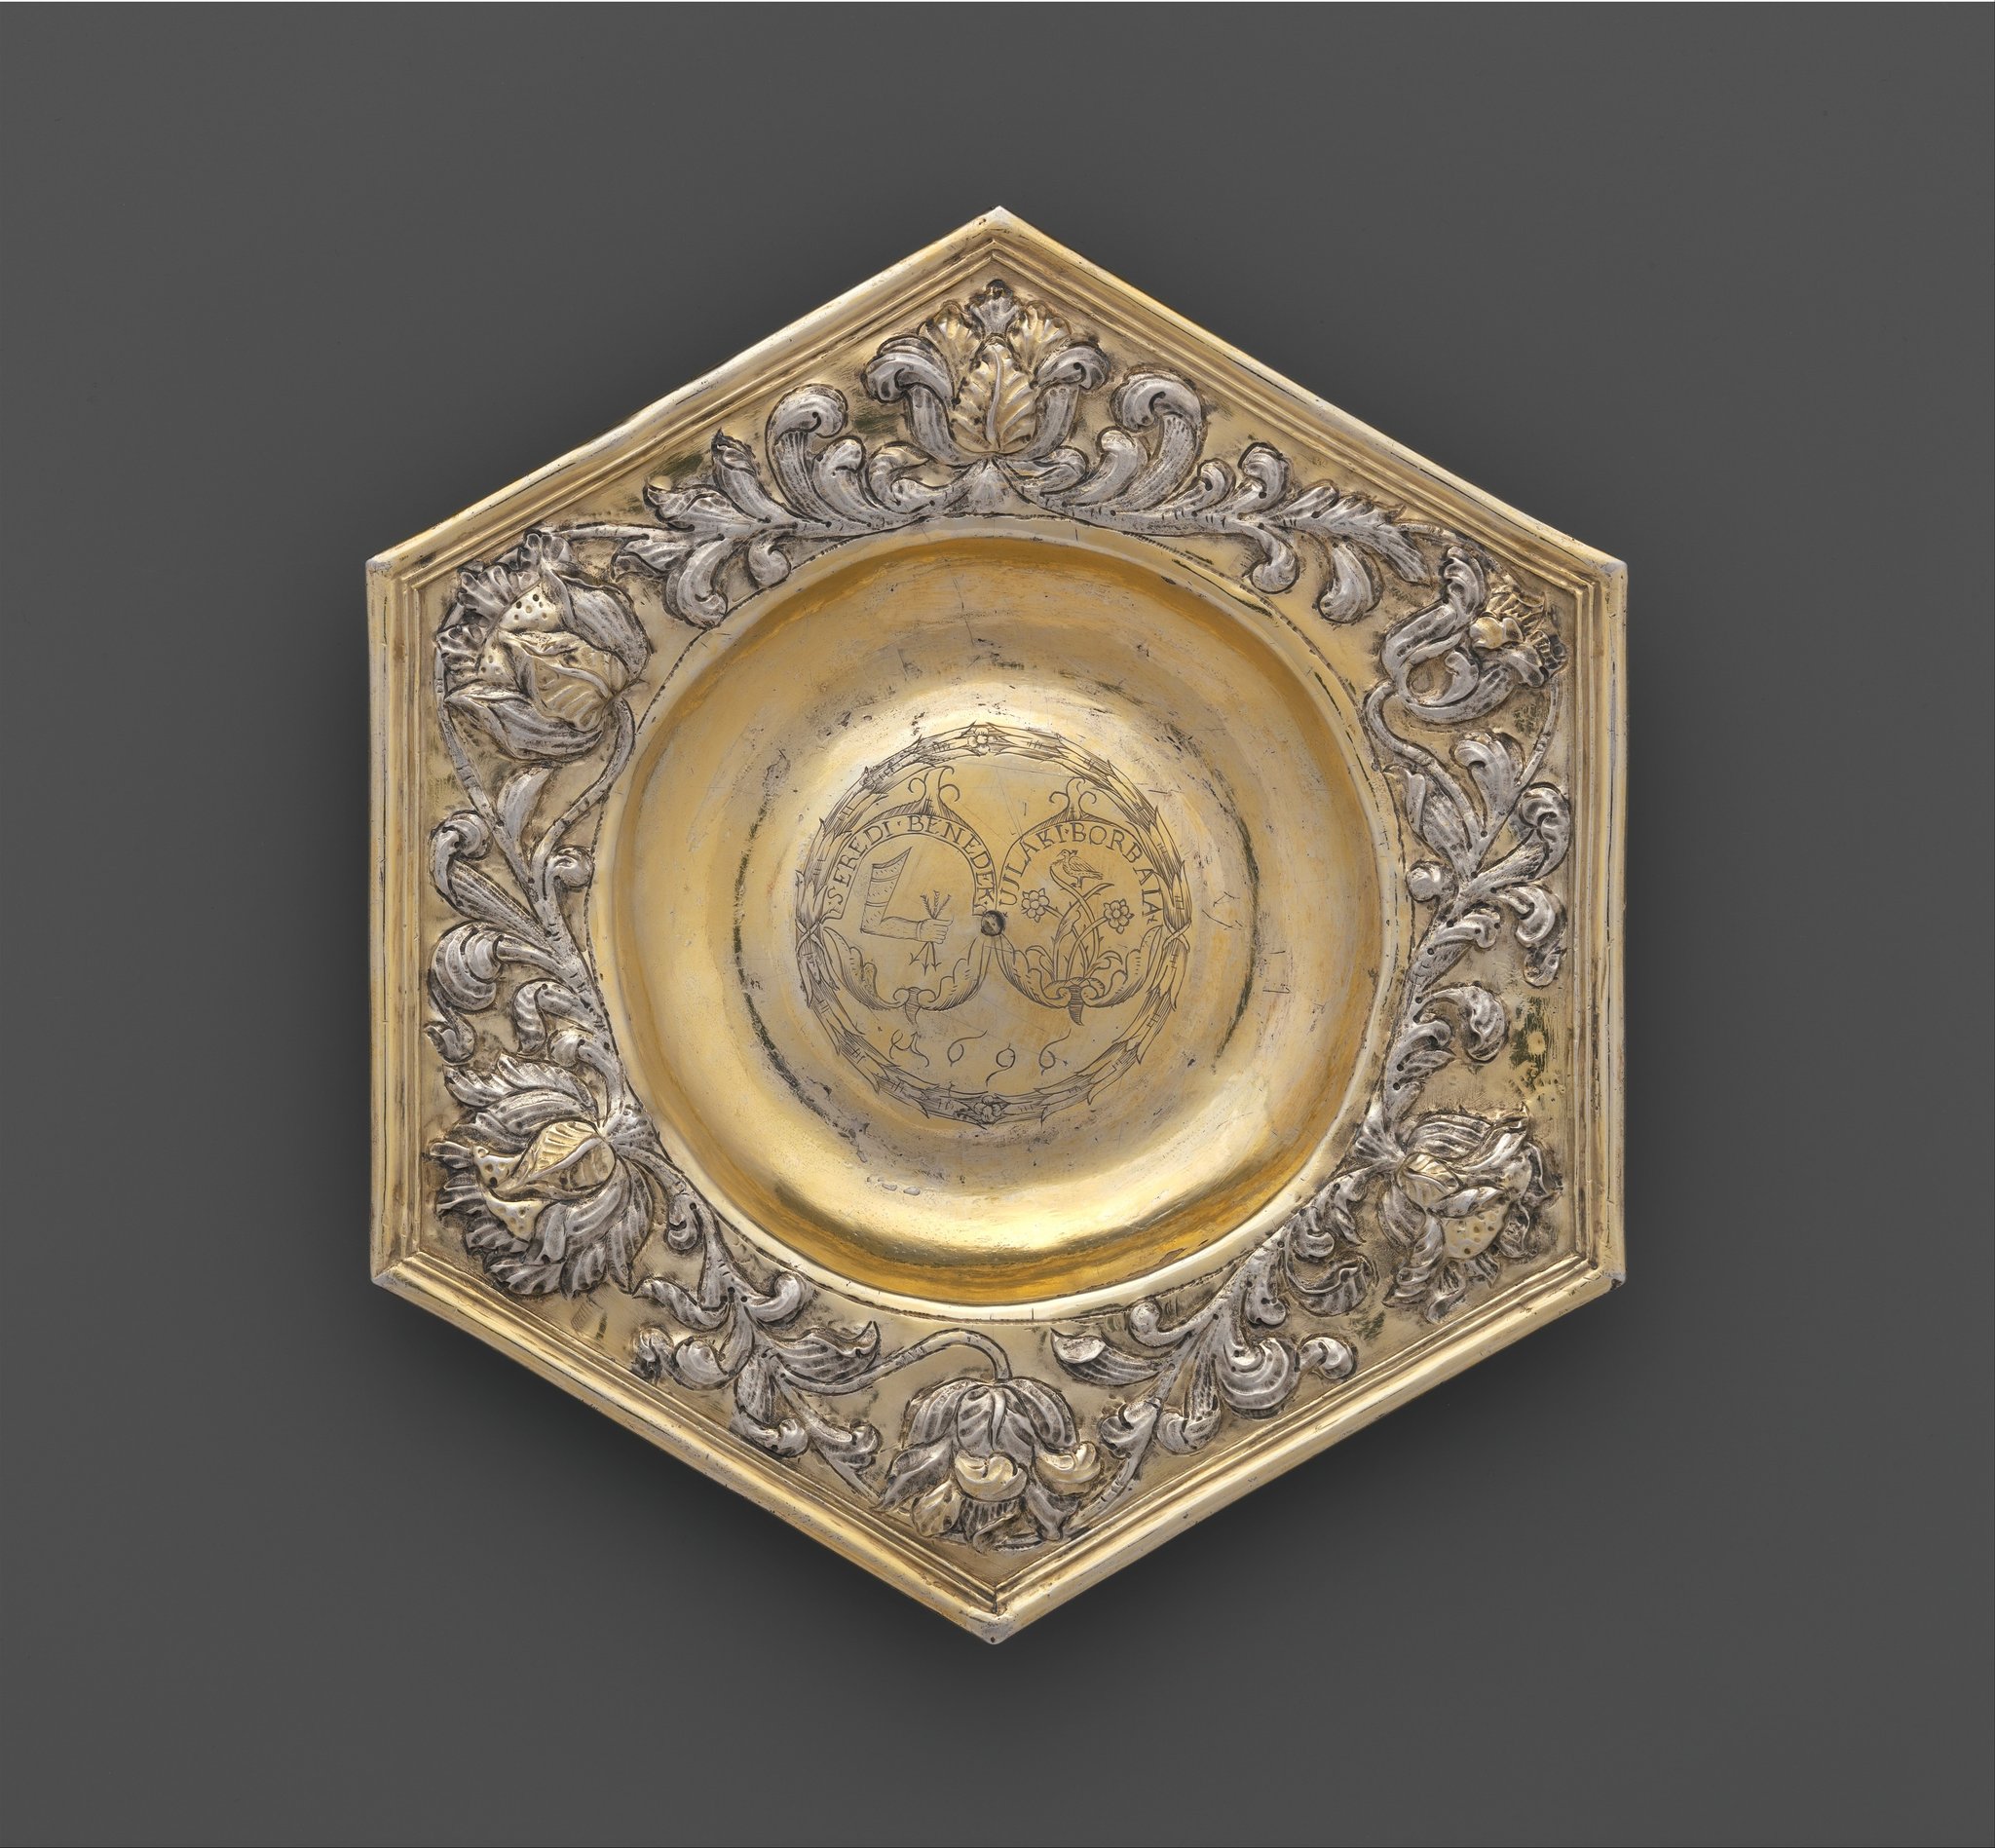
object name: dish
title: Hexagonal dish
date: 1696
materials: silver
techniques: gilding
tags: coat of arms